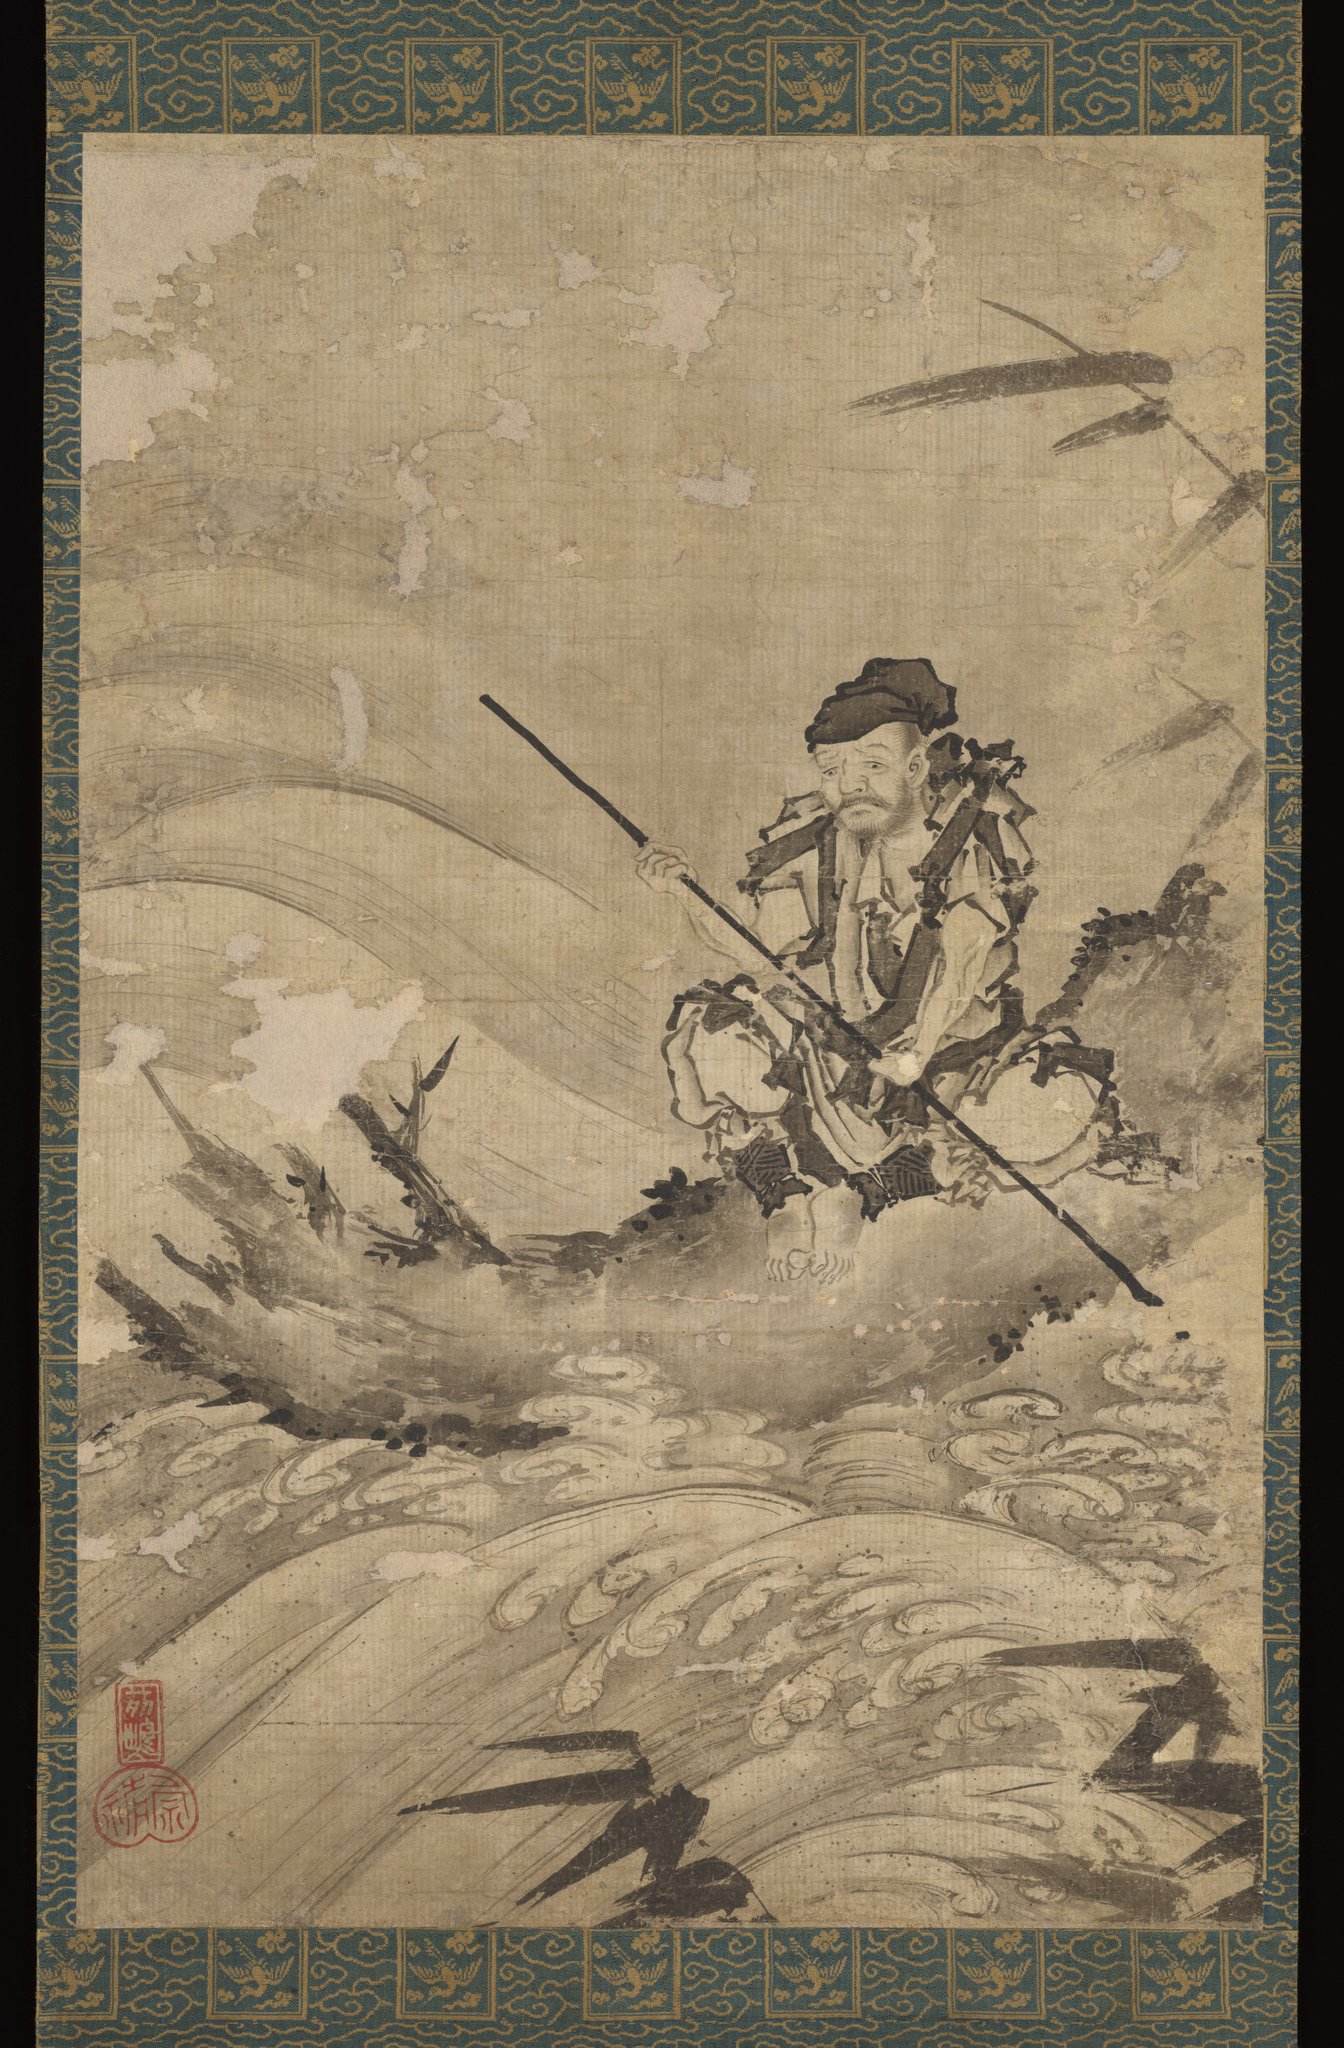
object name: hanging scroll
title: The Chinese Explorer Zhang Qian on a Raft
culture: japanese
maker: maejima sōyū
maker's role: artist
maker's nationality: japanese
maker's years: 1536-1570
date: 1534-1566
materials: ink, paper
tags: men,rivers